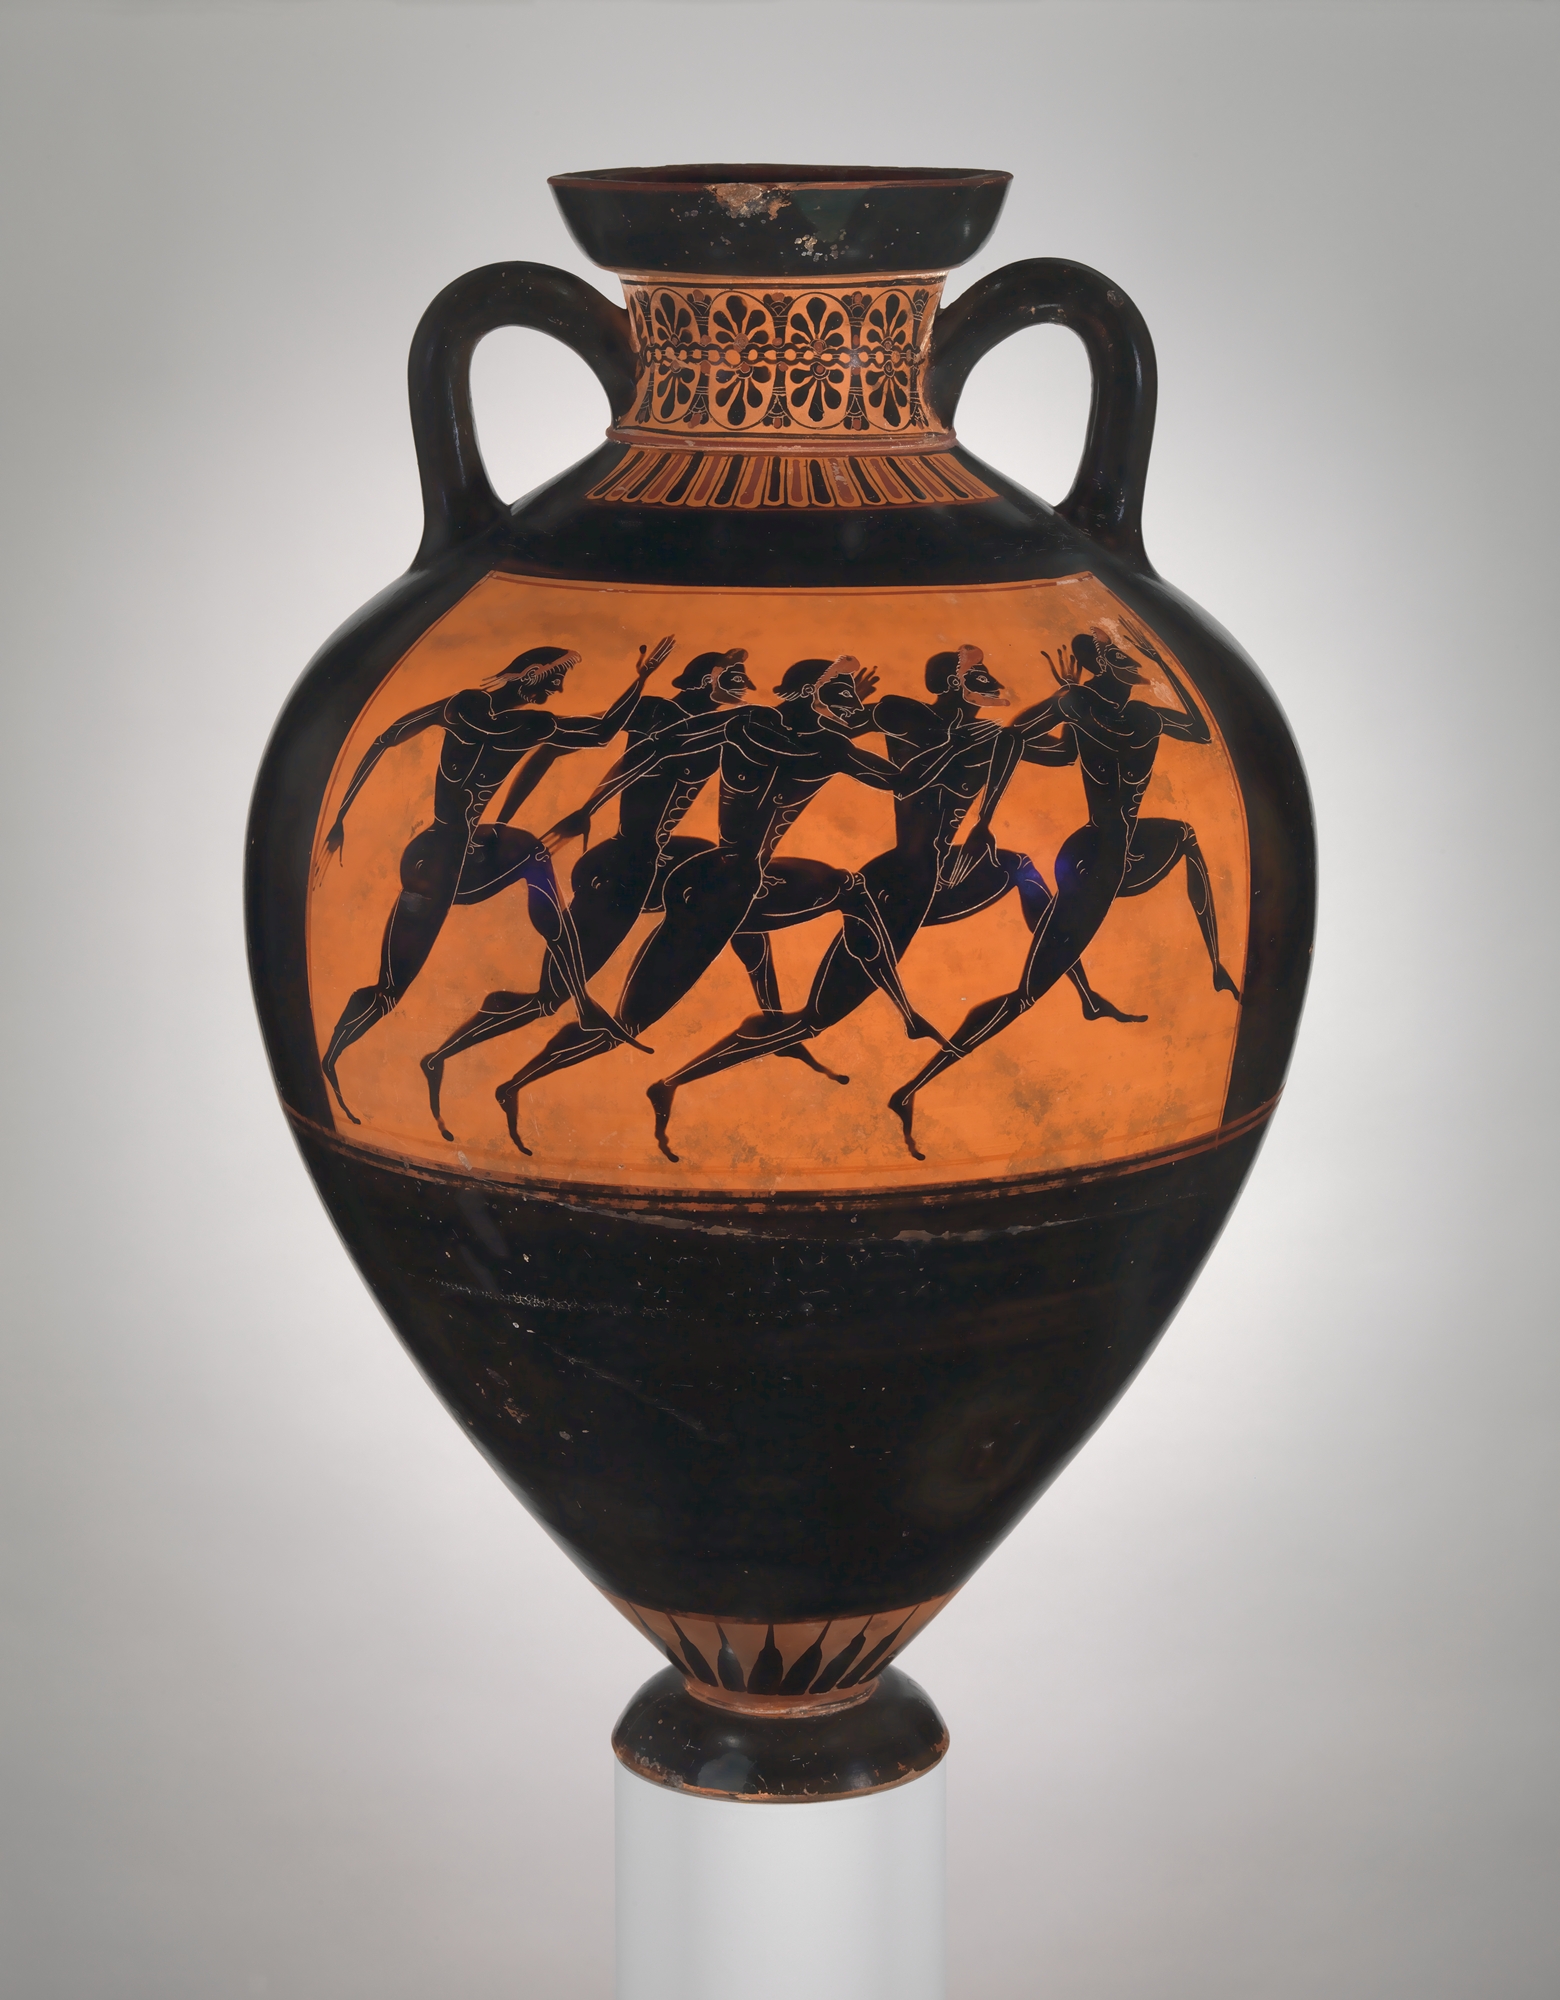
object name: panathenaic prize amphora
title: Terracotta Panathenaic prize amphora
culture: greek, attic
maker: euphiletos painter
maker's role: artist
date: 530 BCE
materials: terracotta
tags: shields,men,male nudes,running,athletes